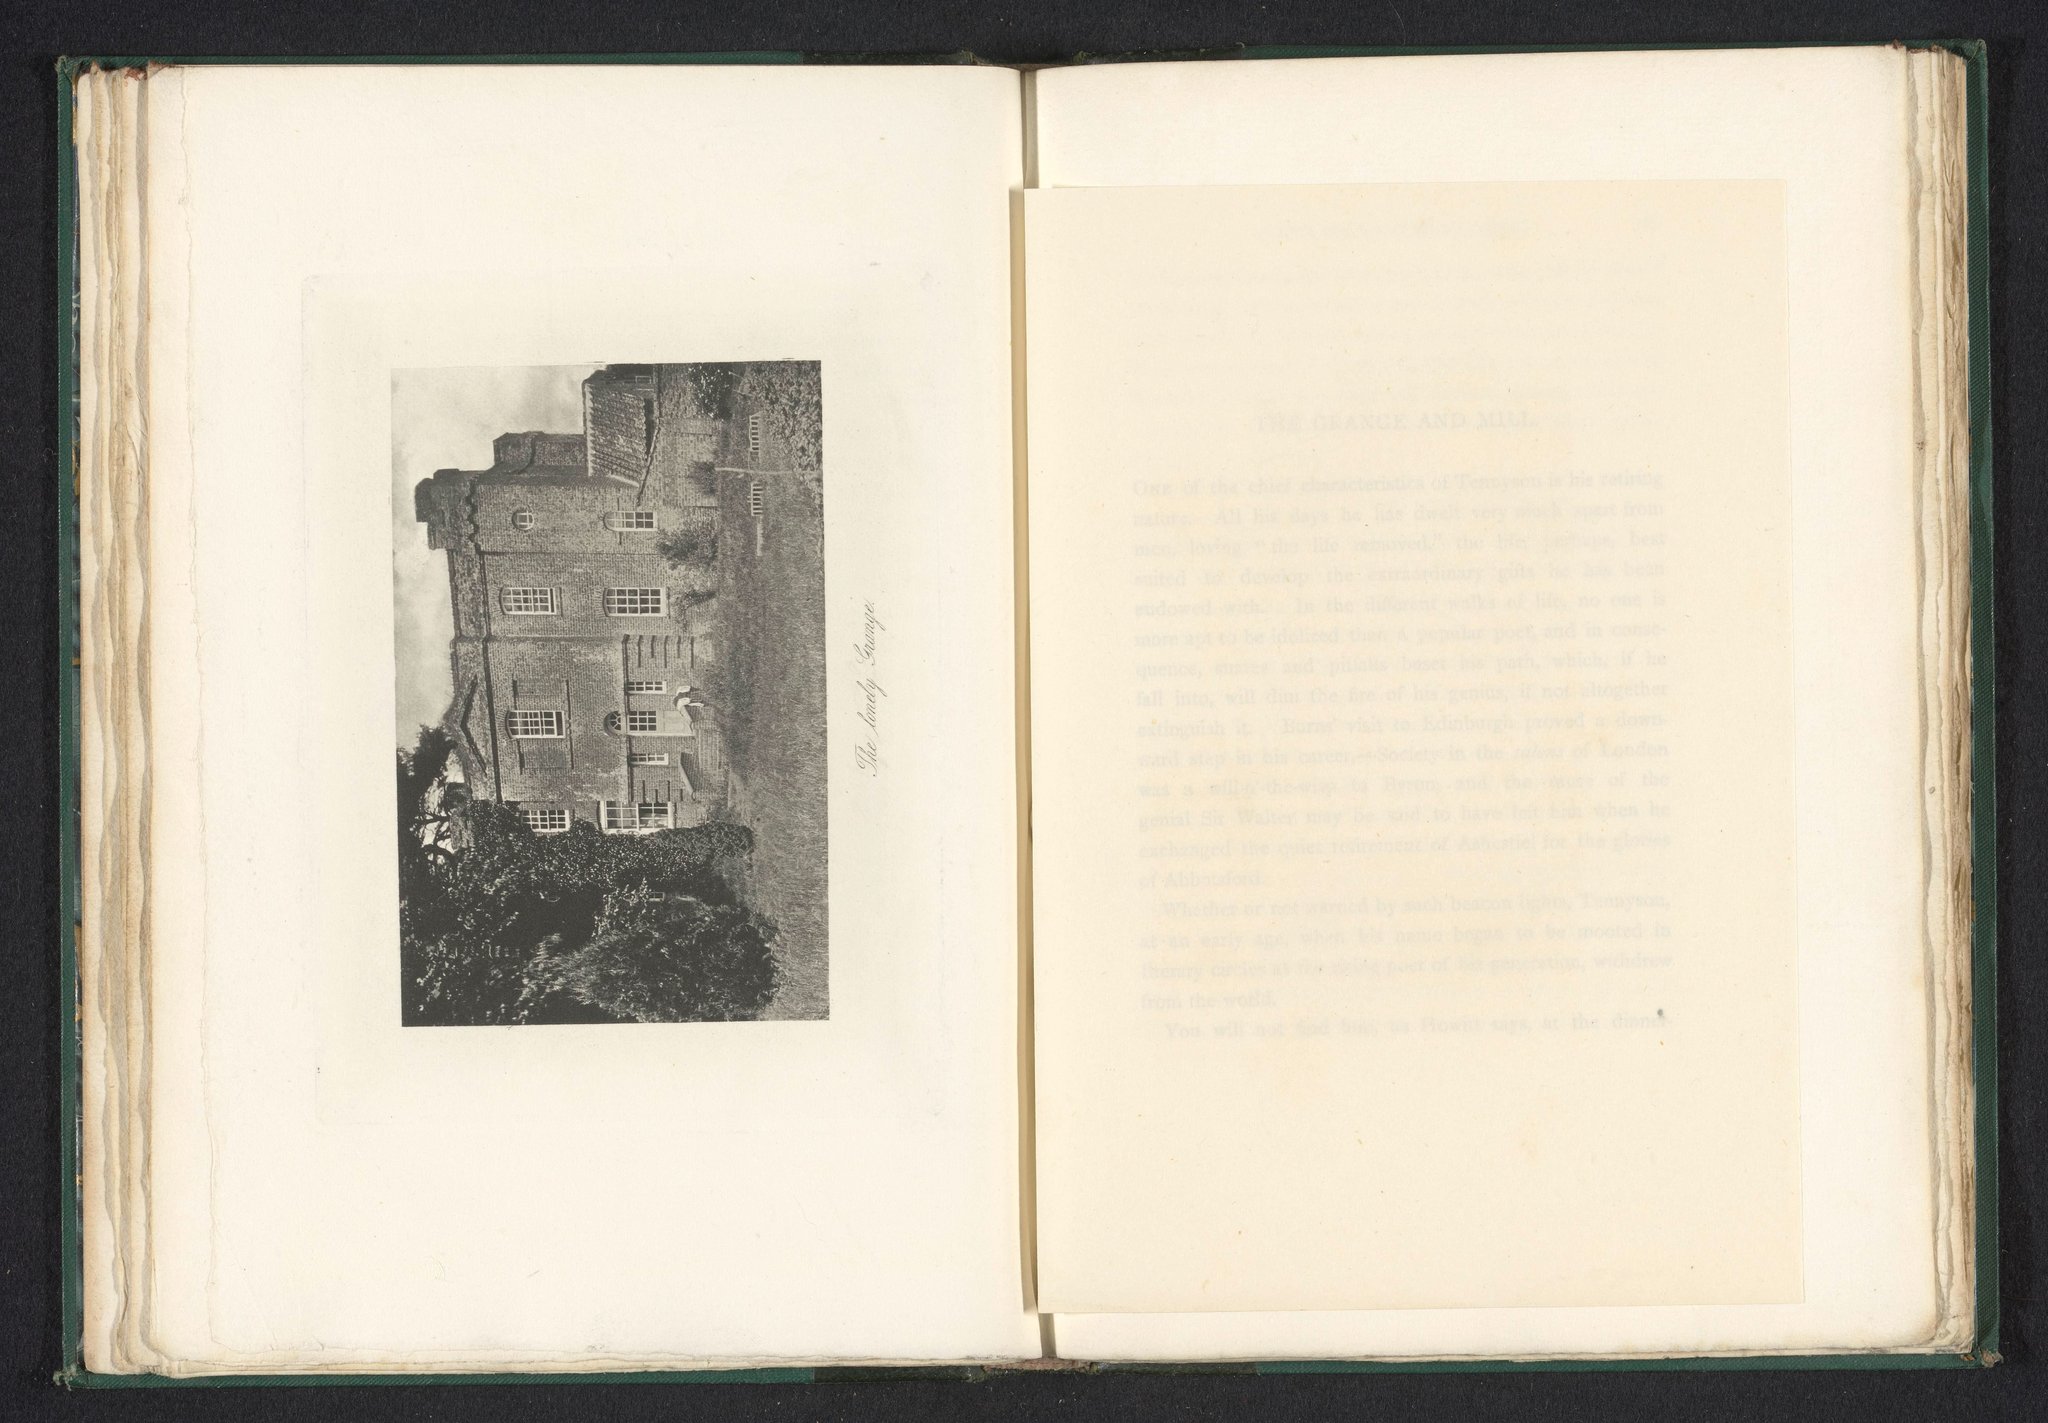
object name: page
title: The lonely grange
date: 1884-1889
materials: paper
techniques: photoaquatint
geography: glasgow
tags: façade (of house or building), country-house